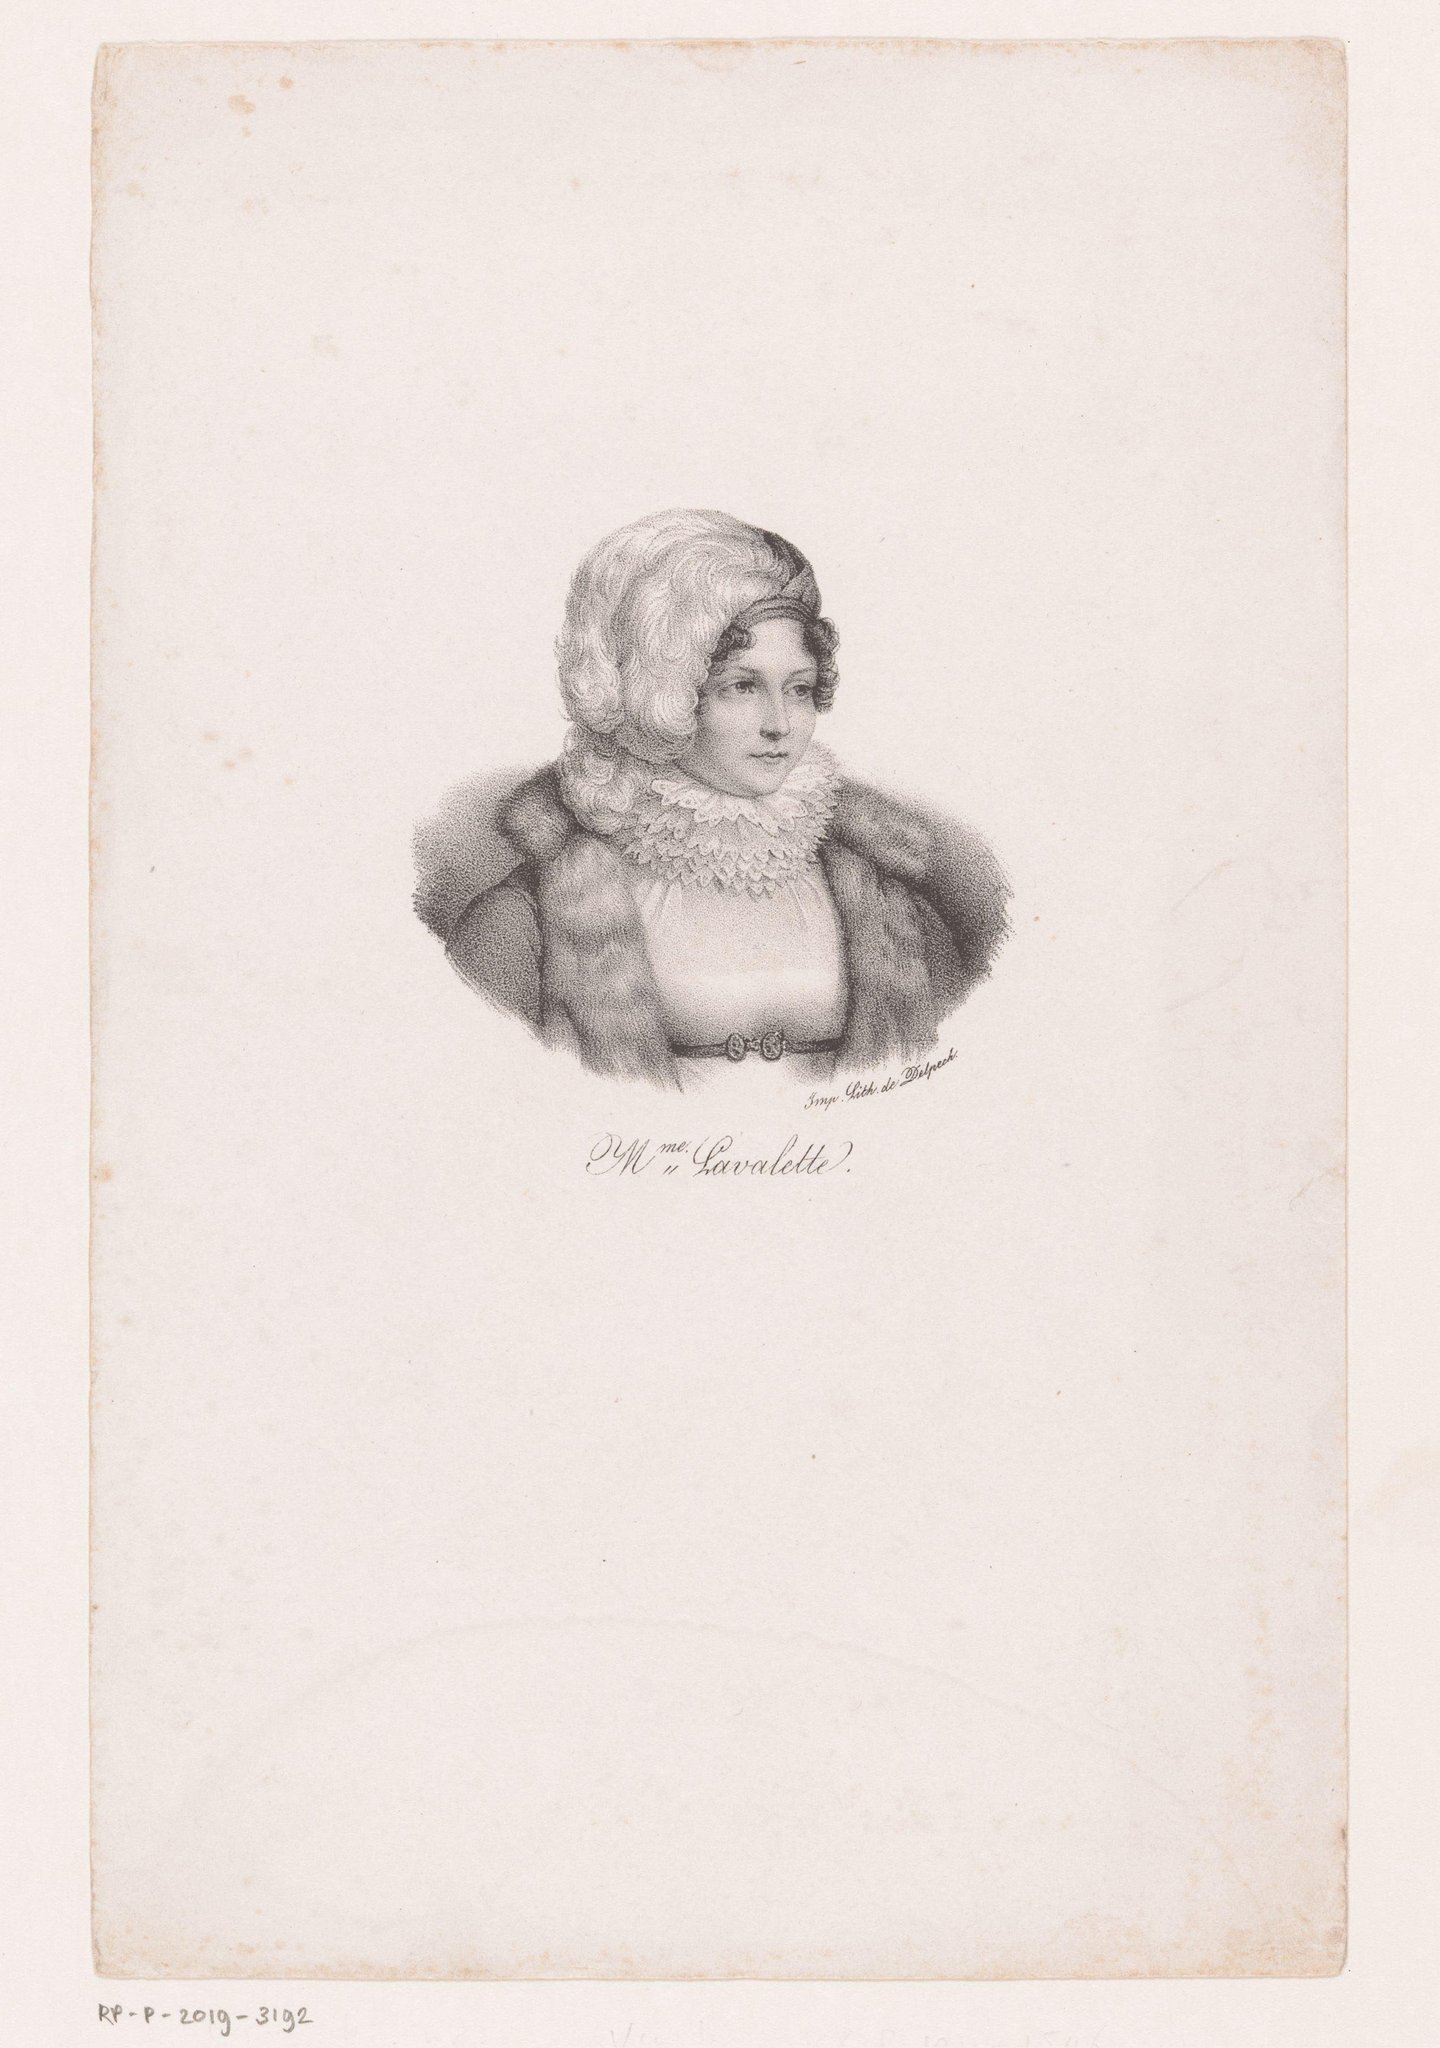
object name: print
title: M.me Lavalette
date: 1825-1842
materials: paper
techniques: lithograph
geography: paris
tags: head-gear and clothing for the upper part of the body, historical persons